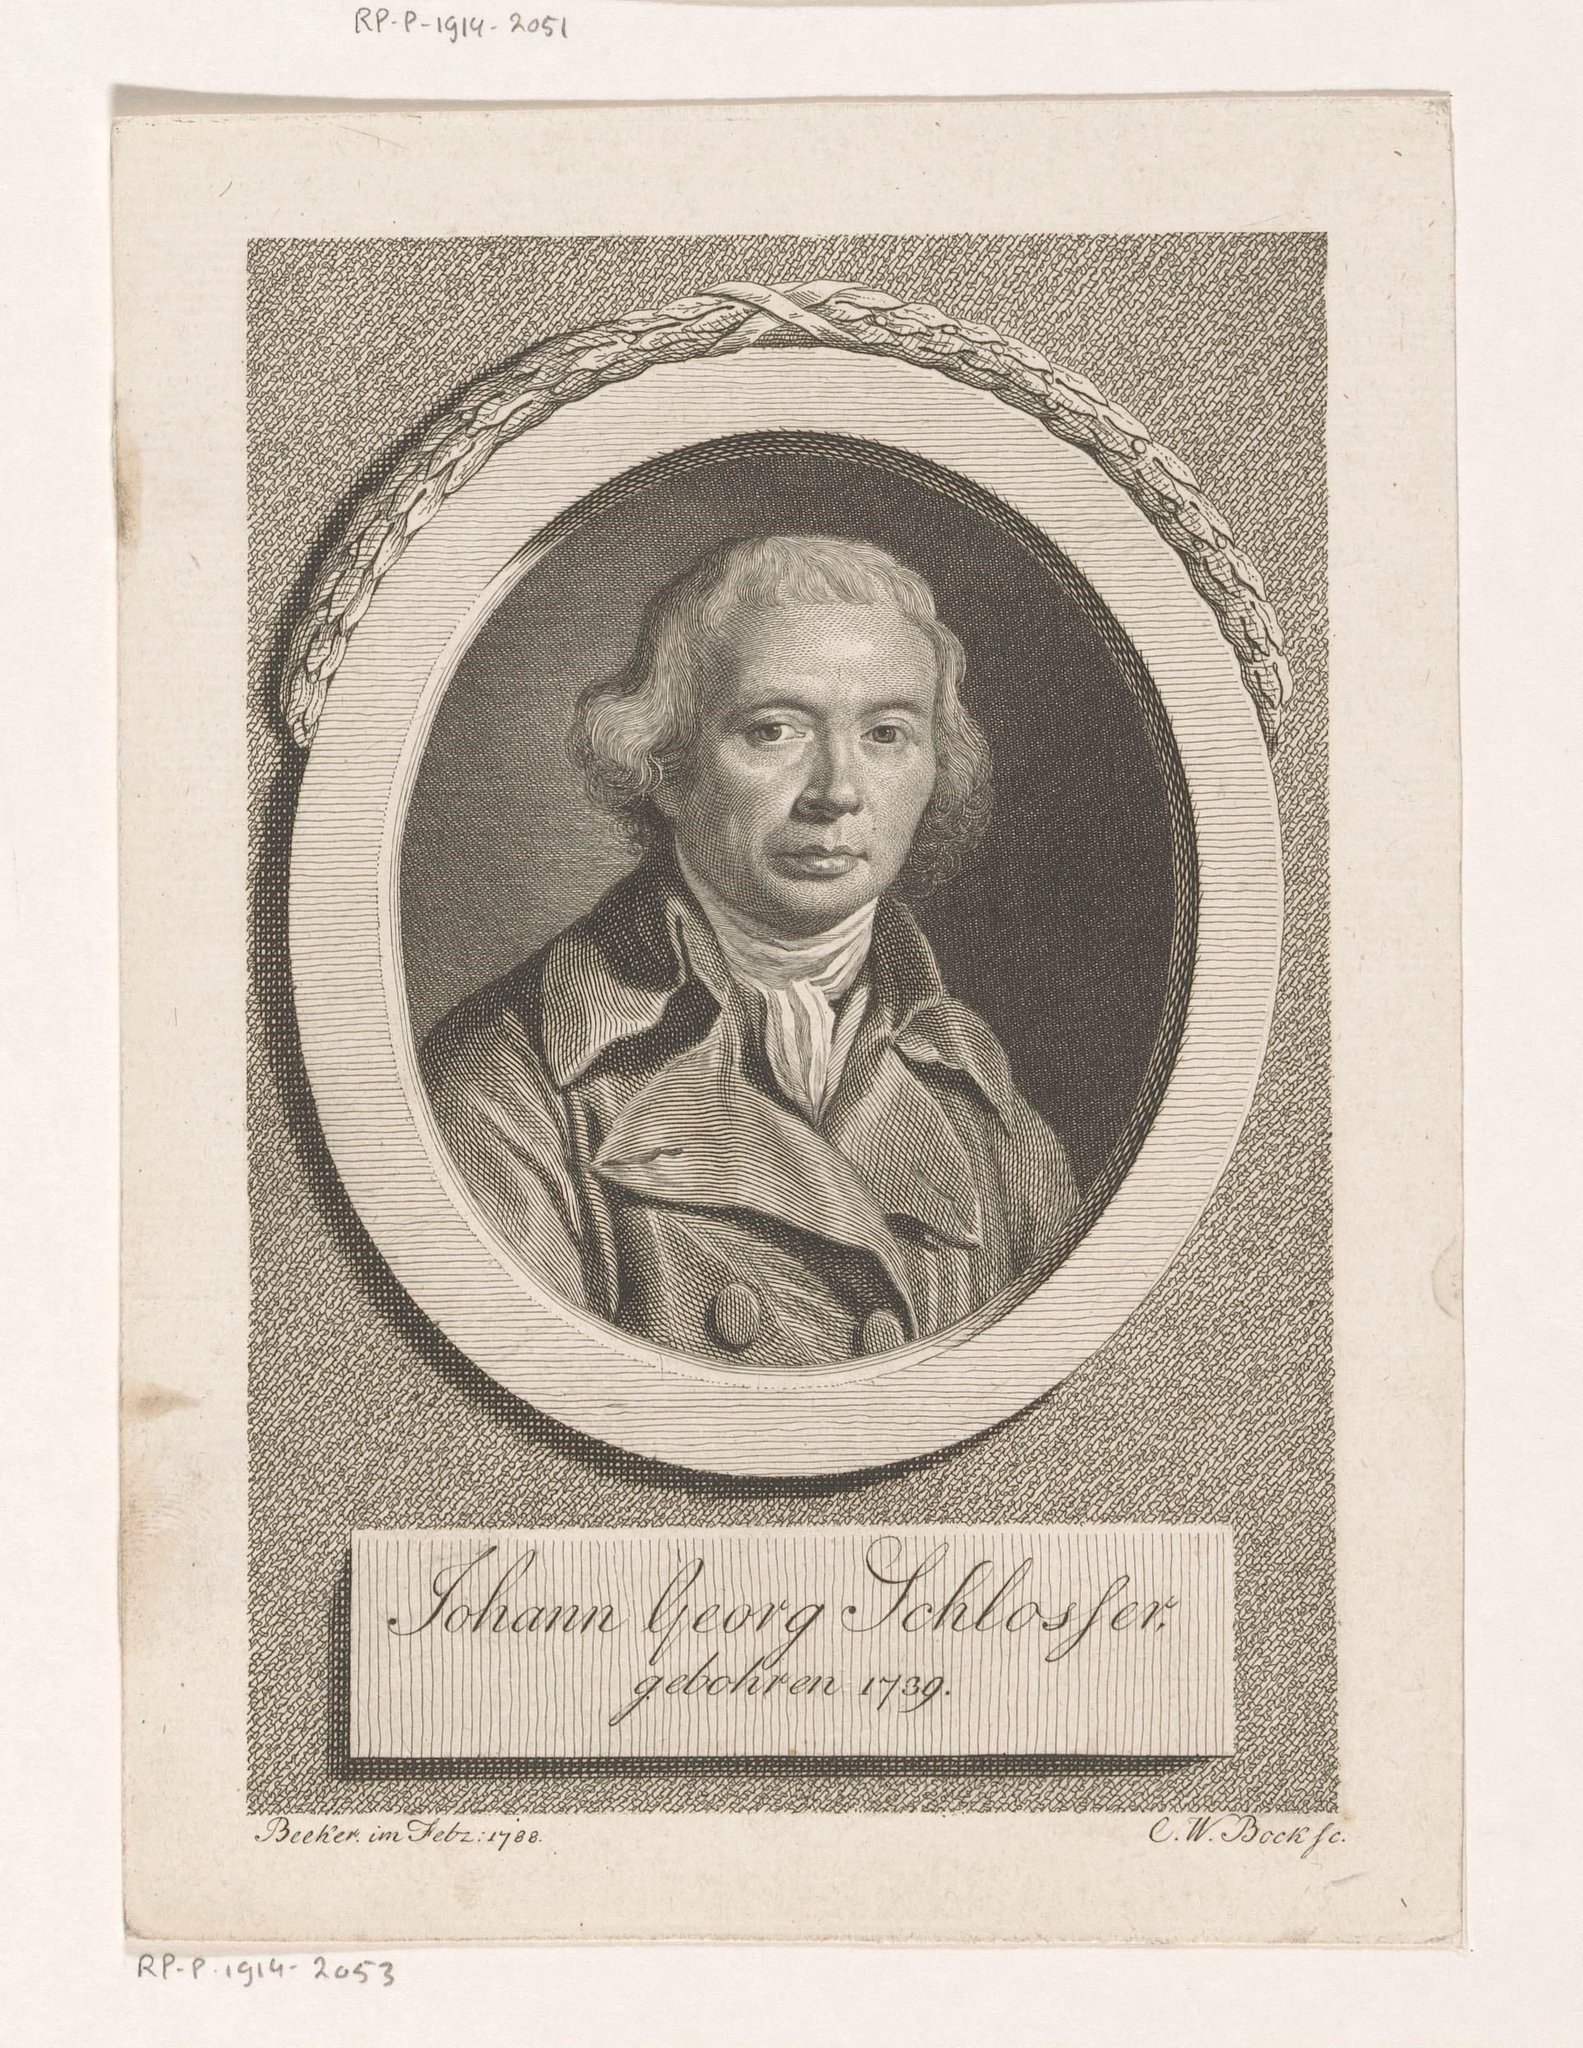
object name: print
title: Portret van Johann Georg Schlosser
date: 1788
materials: paper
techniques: engraving, etching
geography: nuremberg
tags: historical persons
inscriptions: collector's mark: Lugt 3280, collector's mark: Lugt 2228